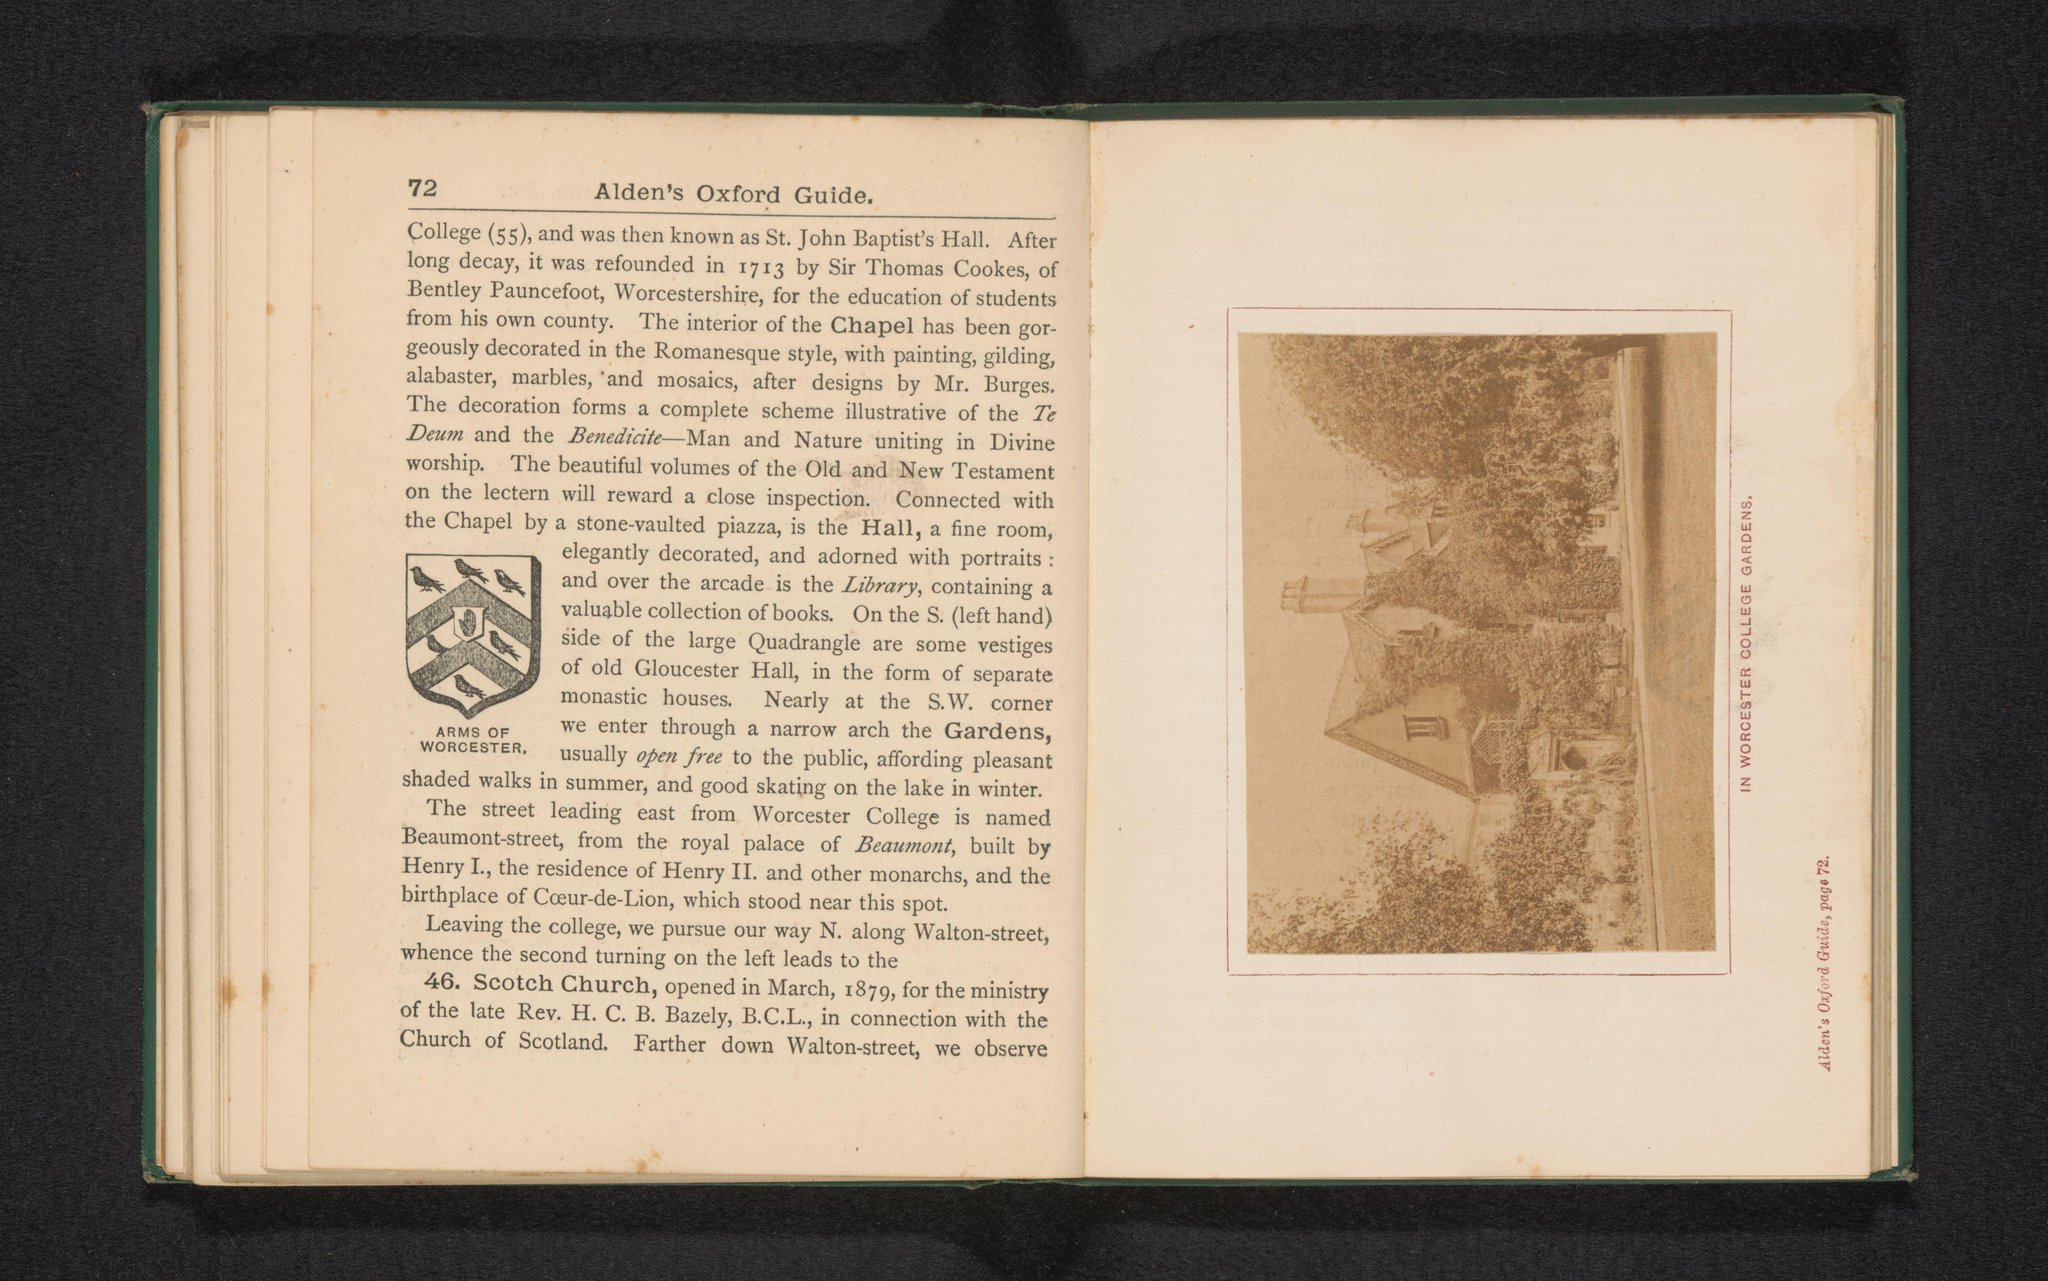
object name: page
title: Gezicht op de tuinen van Worcester College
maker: Anonymous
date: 1878-1883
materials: photographic support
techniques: albumen print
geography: oxford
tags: garden, rural housing, e.g. country-house, villa, cottage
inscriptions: inscription: ‘Allen's Oxgord Guide, Page 72’